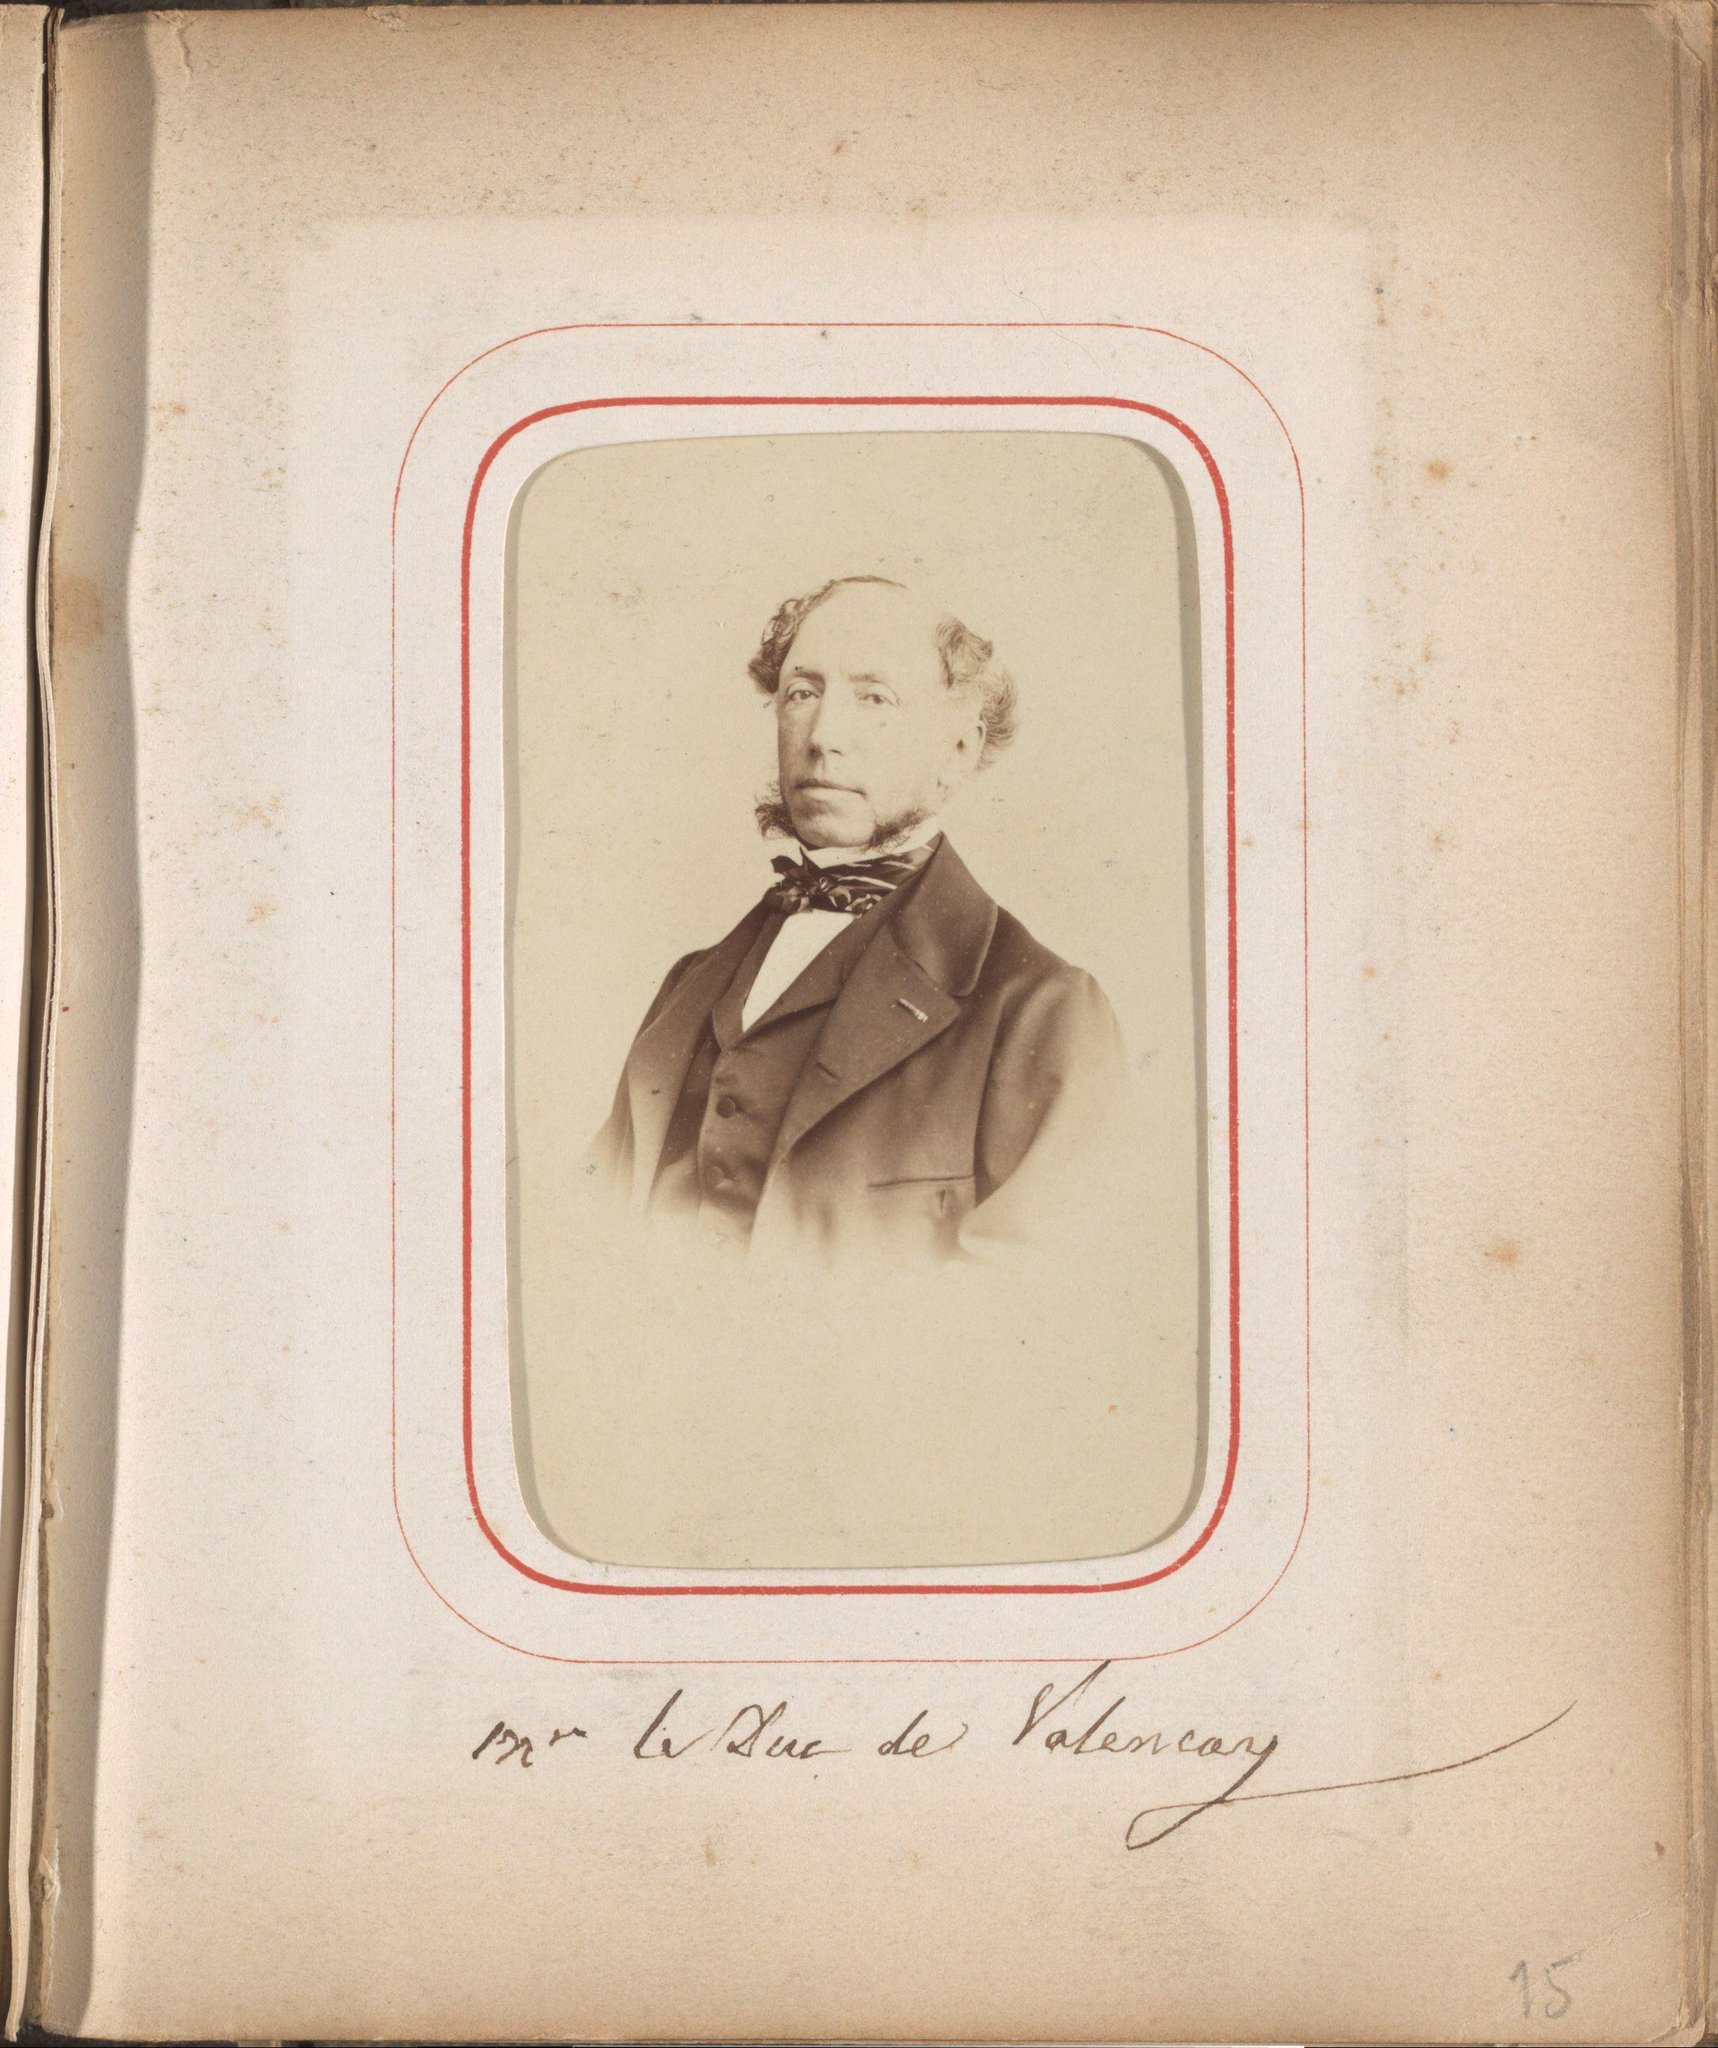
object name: photograph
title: Portret van graaf De Valencay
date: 1860-1865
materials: cardboard, paper, photographic support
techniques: albumen print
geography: berlin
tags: sideburns, historical persons, neck-gear ~ clothing, clothing for the upper part of the body, baldness, berlin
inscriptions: address: ‘2, Zietenplatz, 2, Berlin’, name: ‘Duc de Valencay’, name: ‘Mr. le Duc de Valencay’